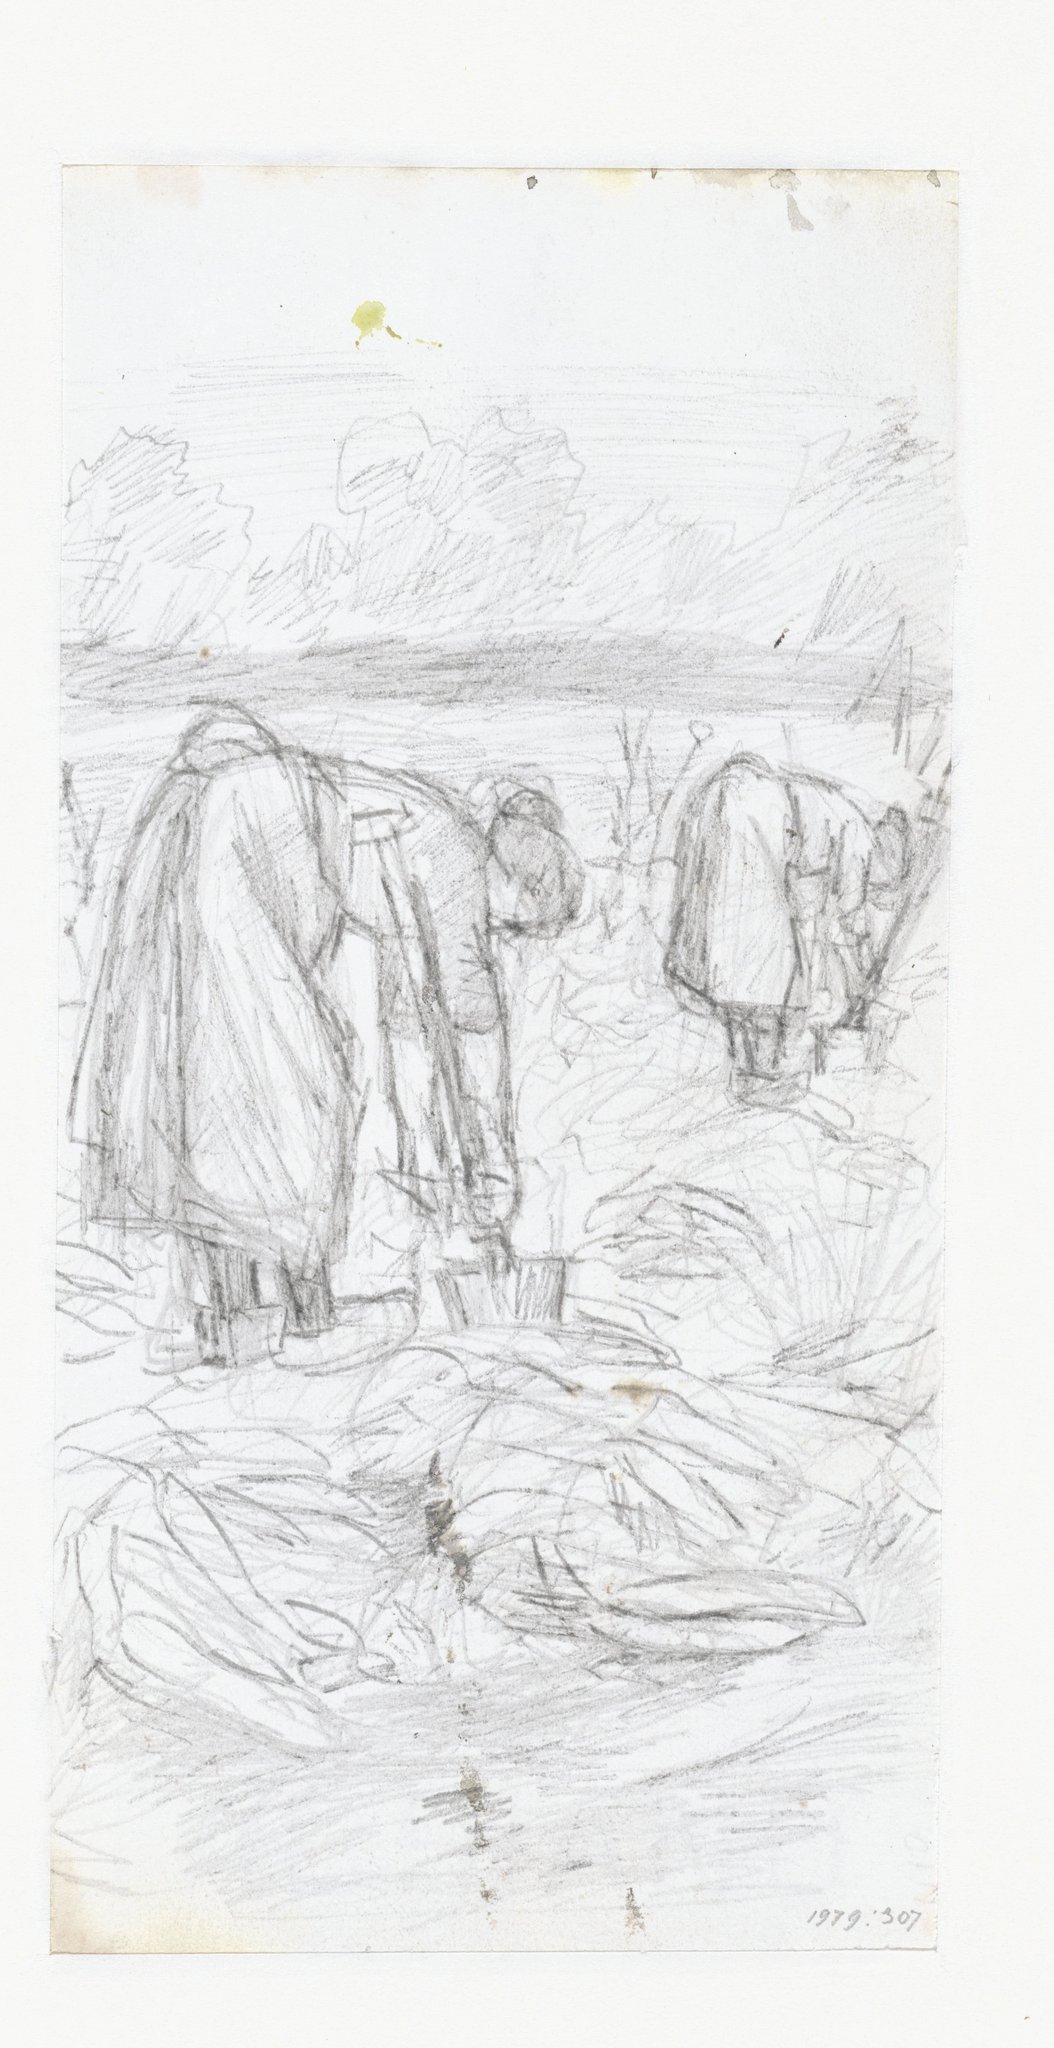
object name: drawing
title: Twee vrouwen werkend op het land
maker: jozef israëls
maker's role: draughtsman, painter, print maker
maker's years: 1824-1911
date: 1834-1911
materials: paper, pencil